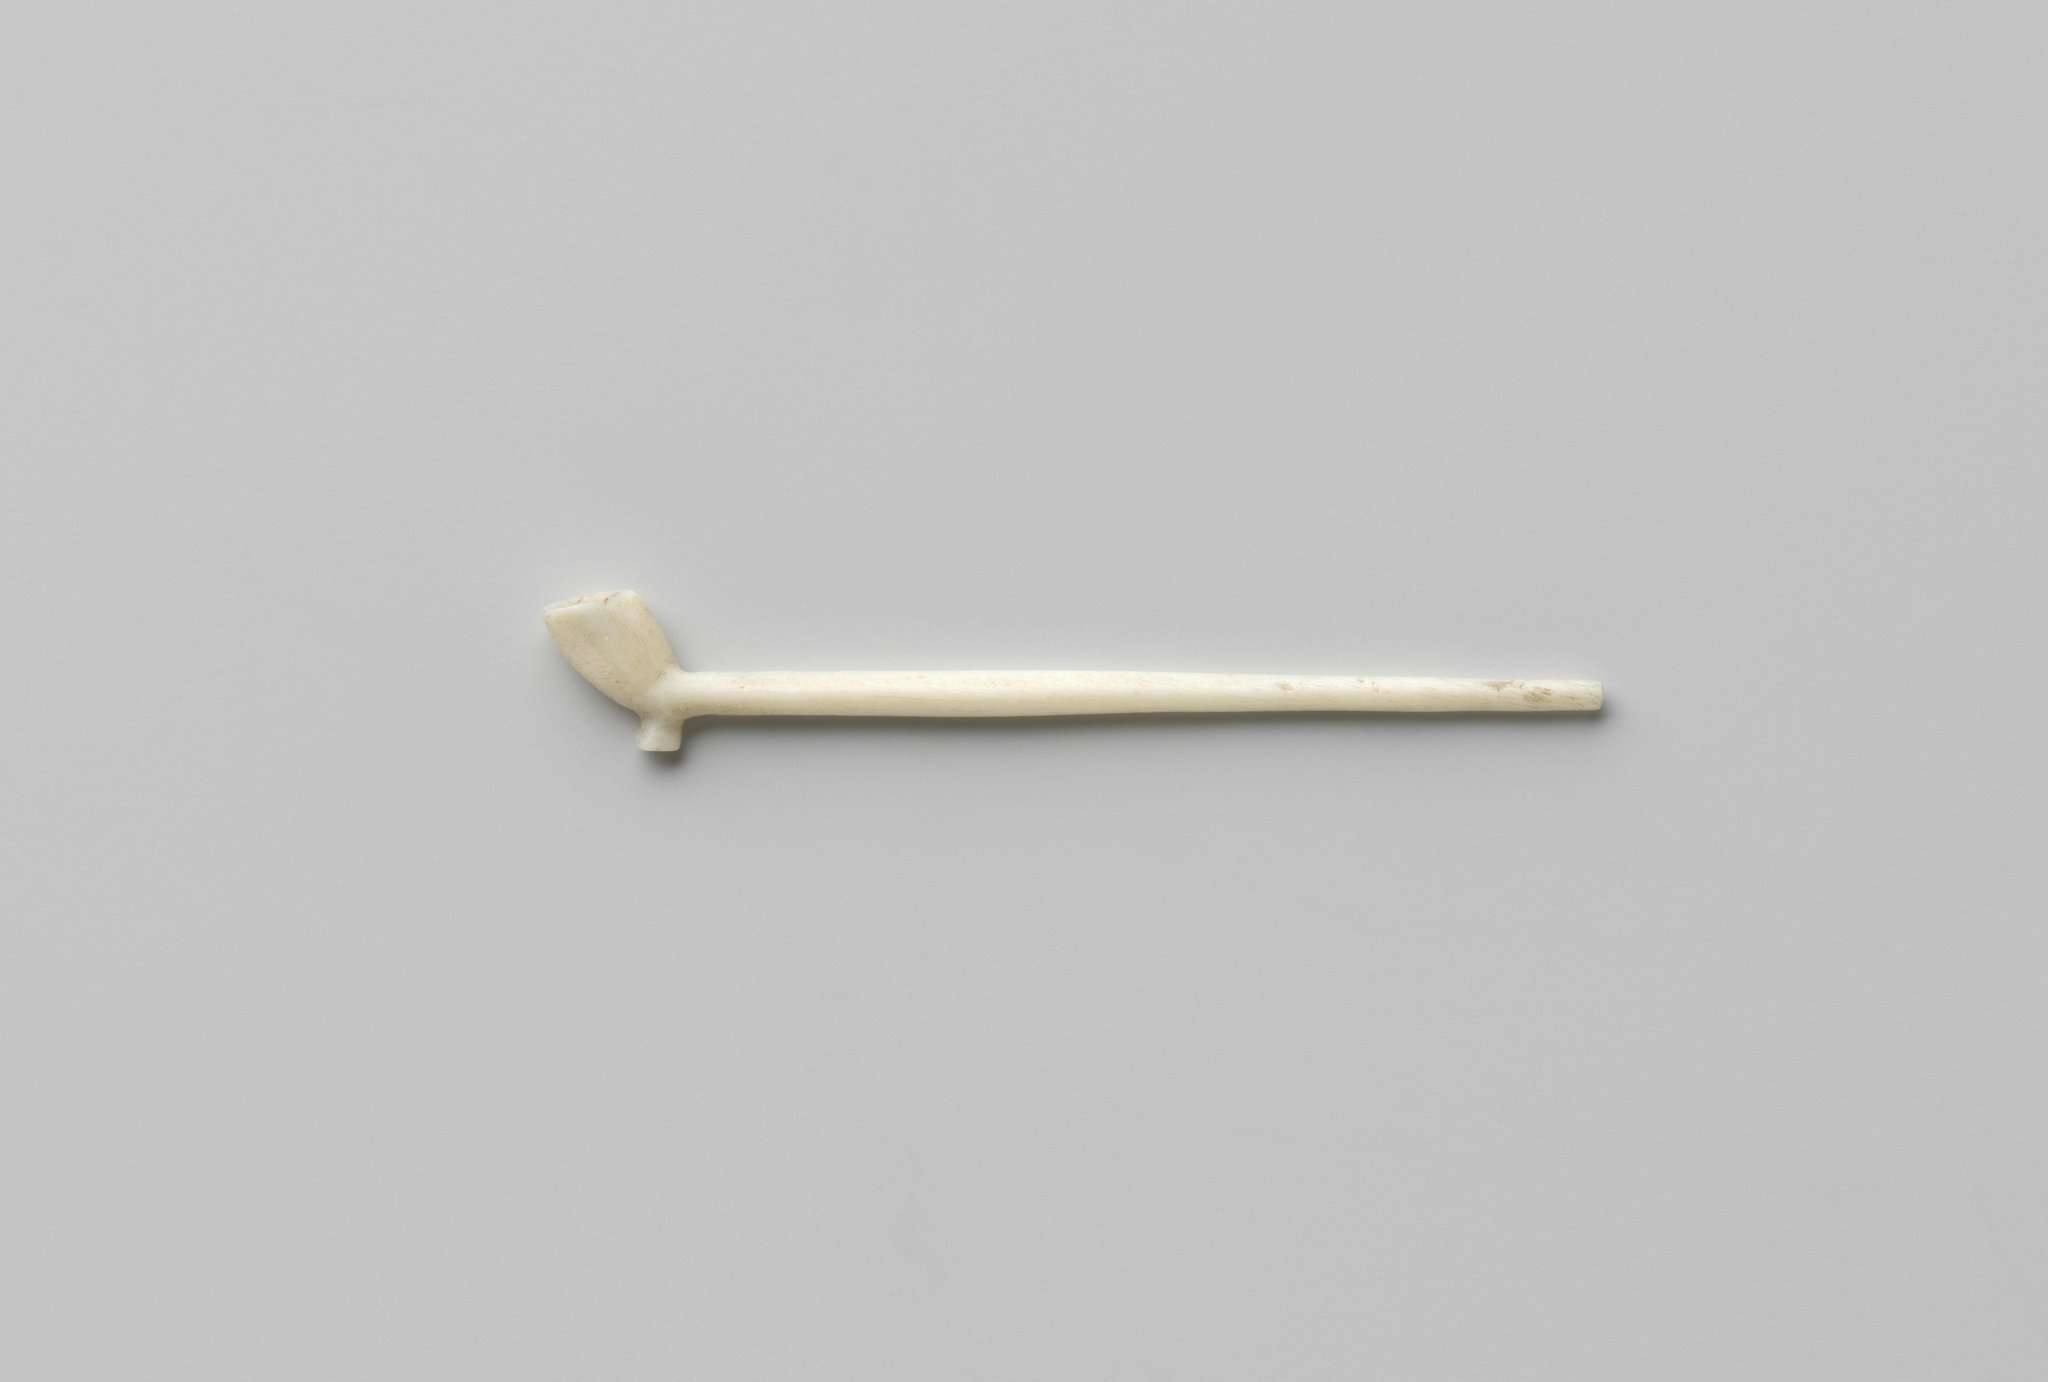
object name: pipe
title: Pijp, model 'Goudse' pijp met lange steel en kop met hiel, vervaardigd van been.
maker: Anonymous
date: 1690-1710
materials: bone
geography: amsterdam